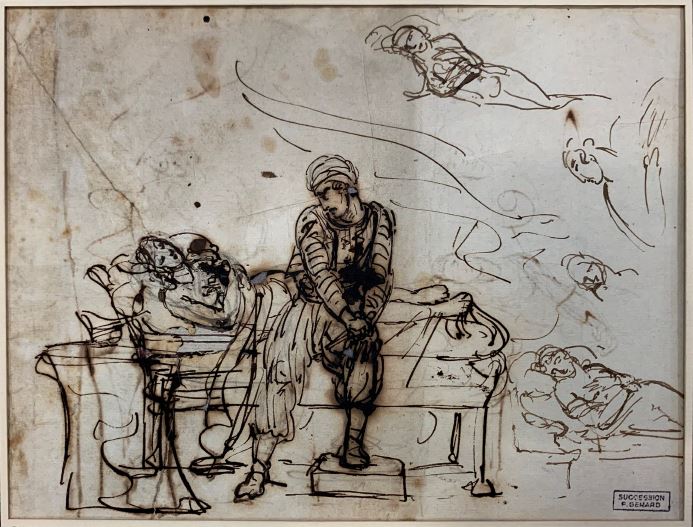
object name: drawing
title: Othello Hesitating to Kill Desdemona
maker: baron françois gérard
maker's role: artist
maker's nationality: french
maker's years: 1770-1837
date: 1795-1810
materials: chalk, ink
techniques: pen